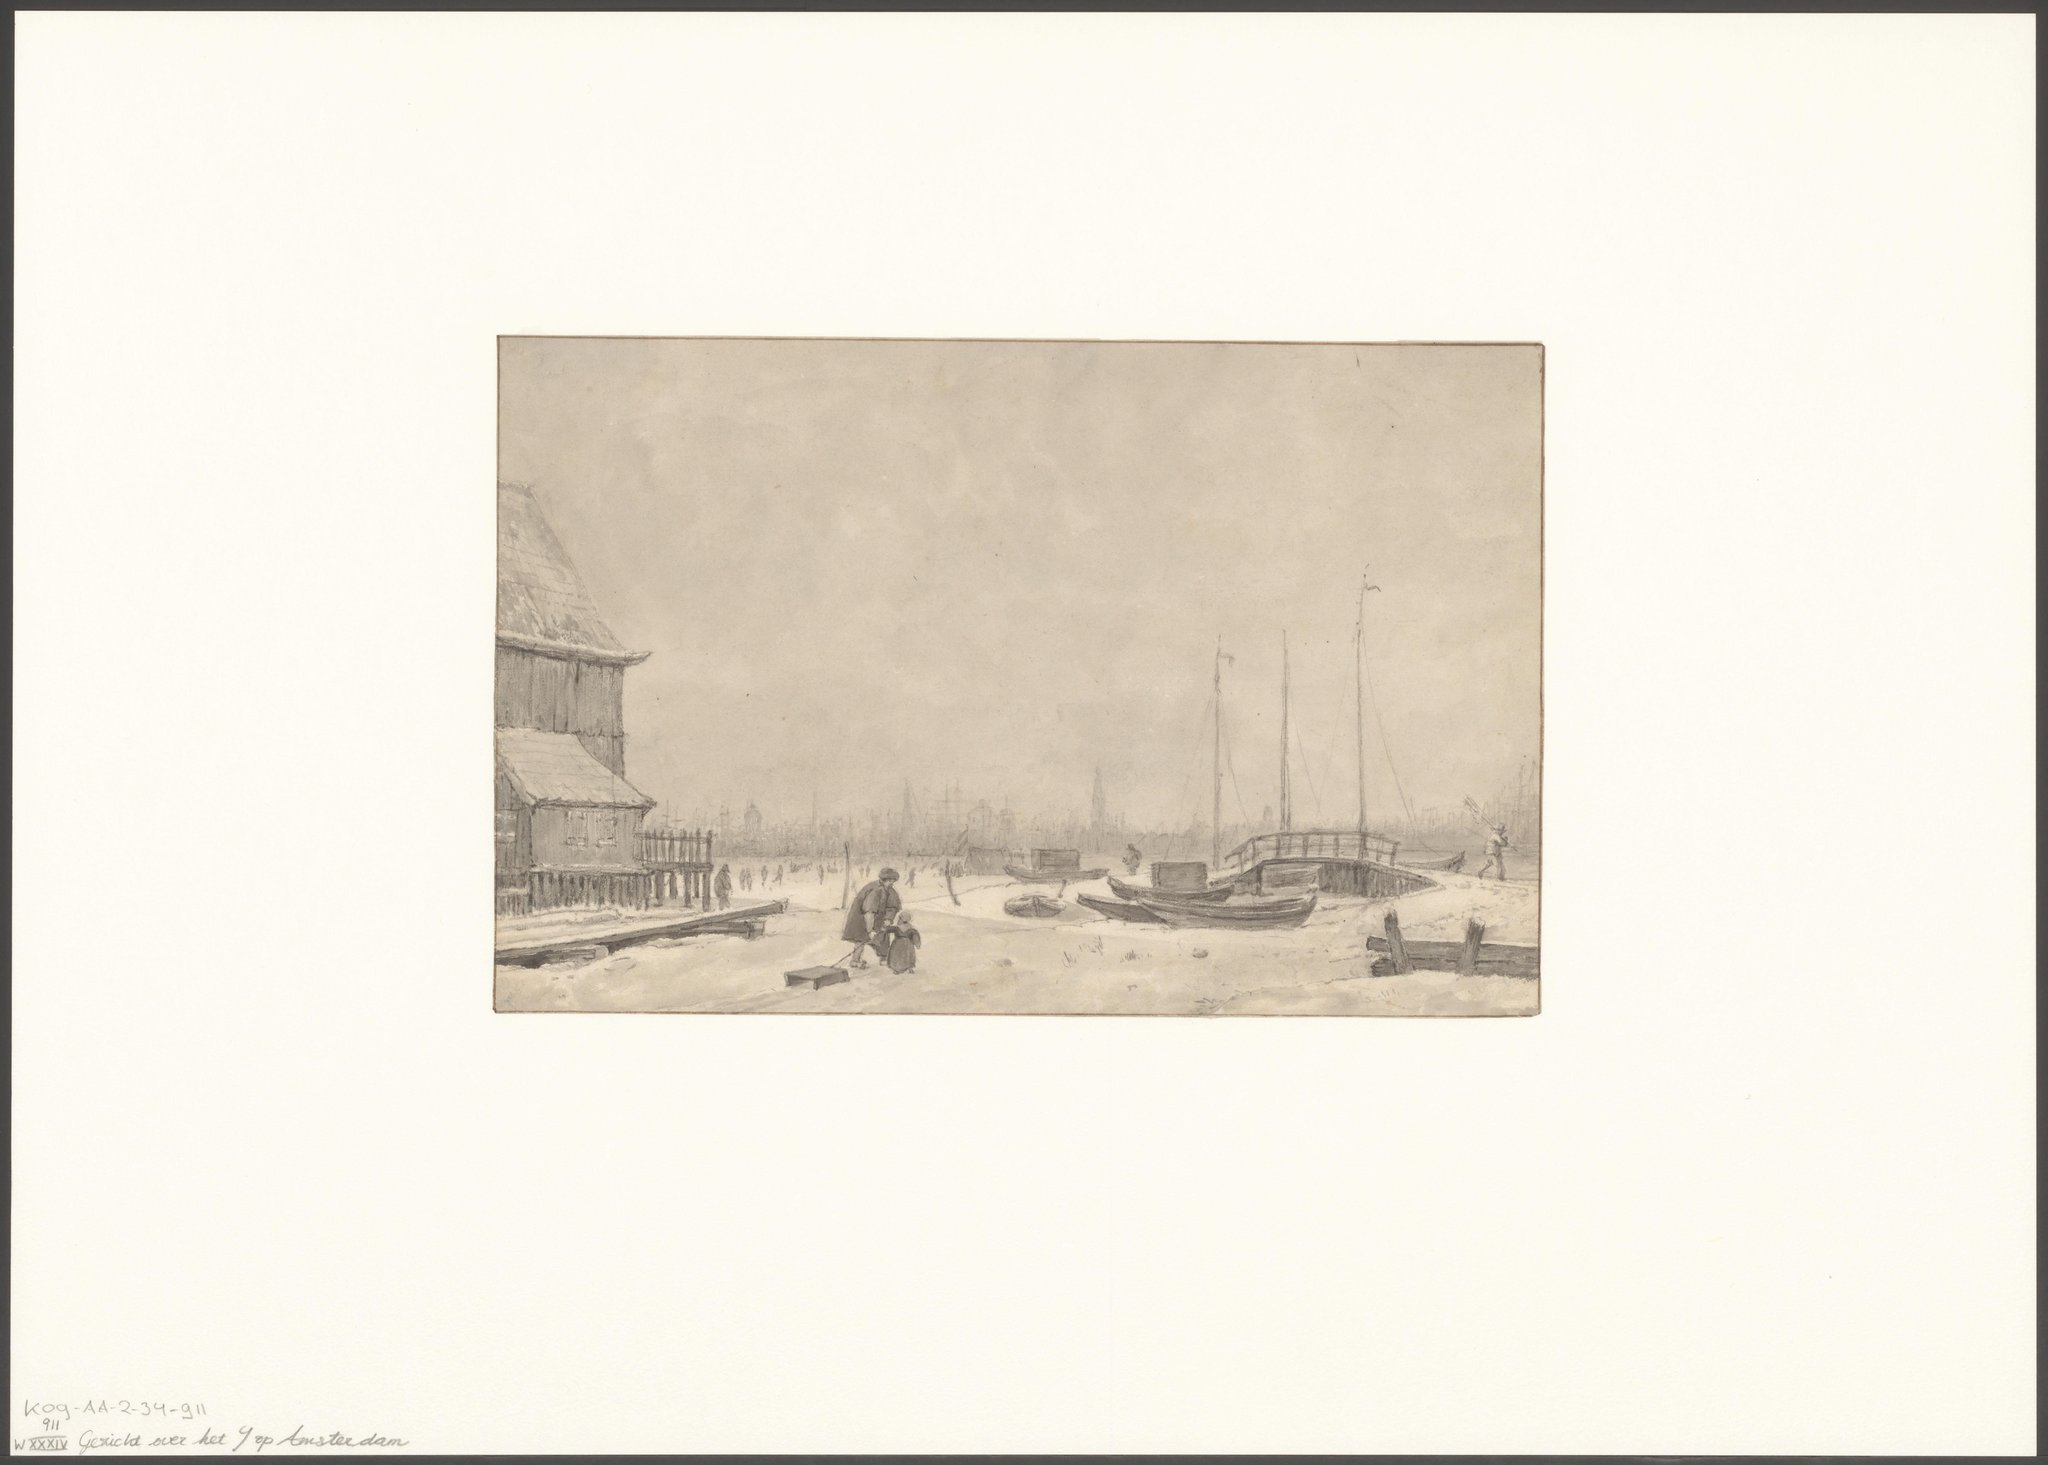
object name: drawing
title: Gezicht op Amsterdam over het IJ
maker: Anonymous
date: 1700-1799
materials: chalk, ink, paper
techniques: brush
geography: amsterdam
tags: sailing-ship, sailing-boat, city-view in general; 'veduta', canal, bridge in city across river, canal, etc., amsterdam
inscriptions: collector's mark: Lugt 800a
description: Tekening binnen de Atlas Van Eck ingedeeld op wijknummer 34.